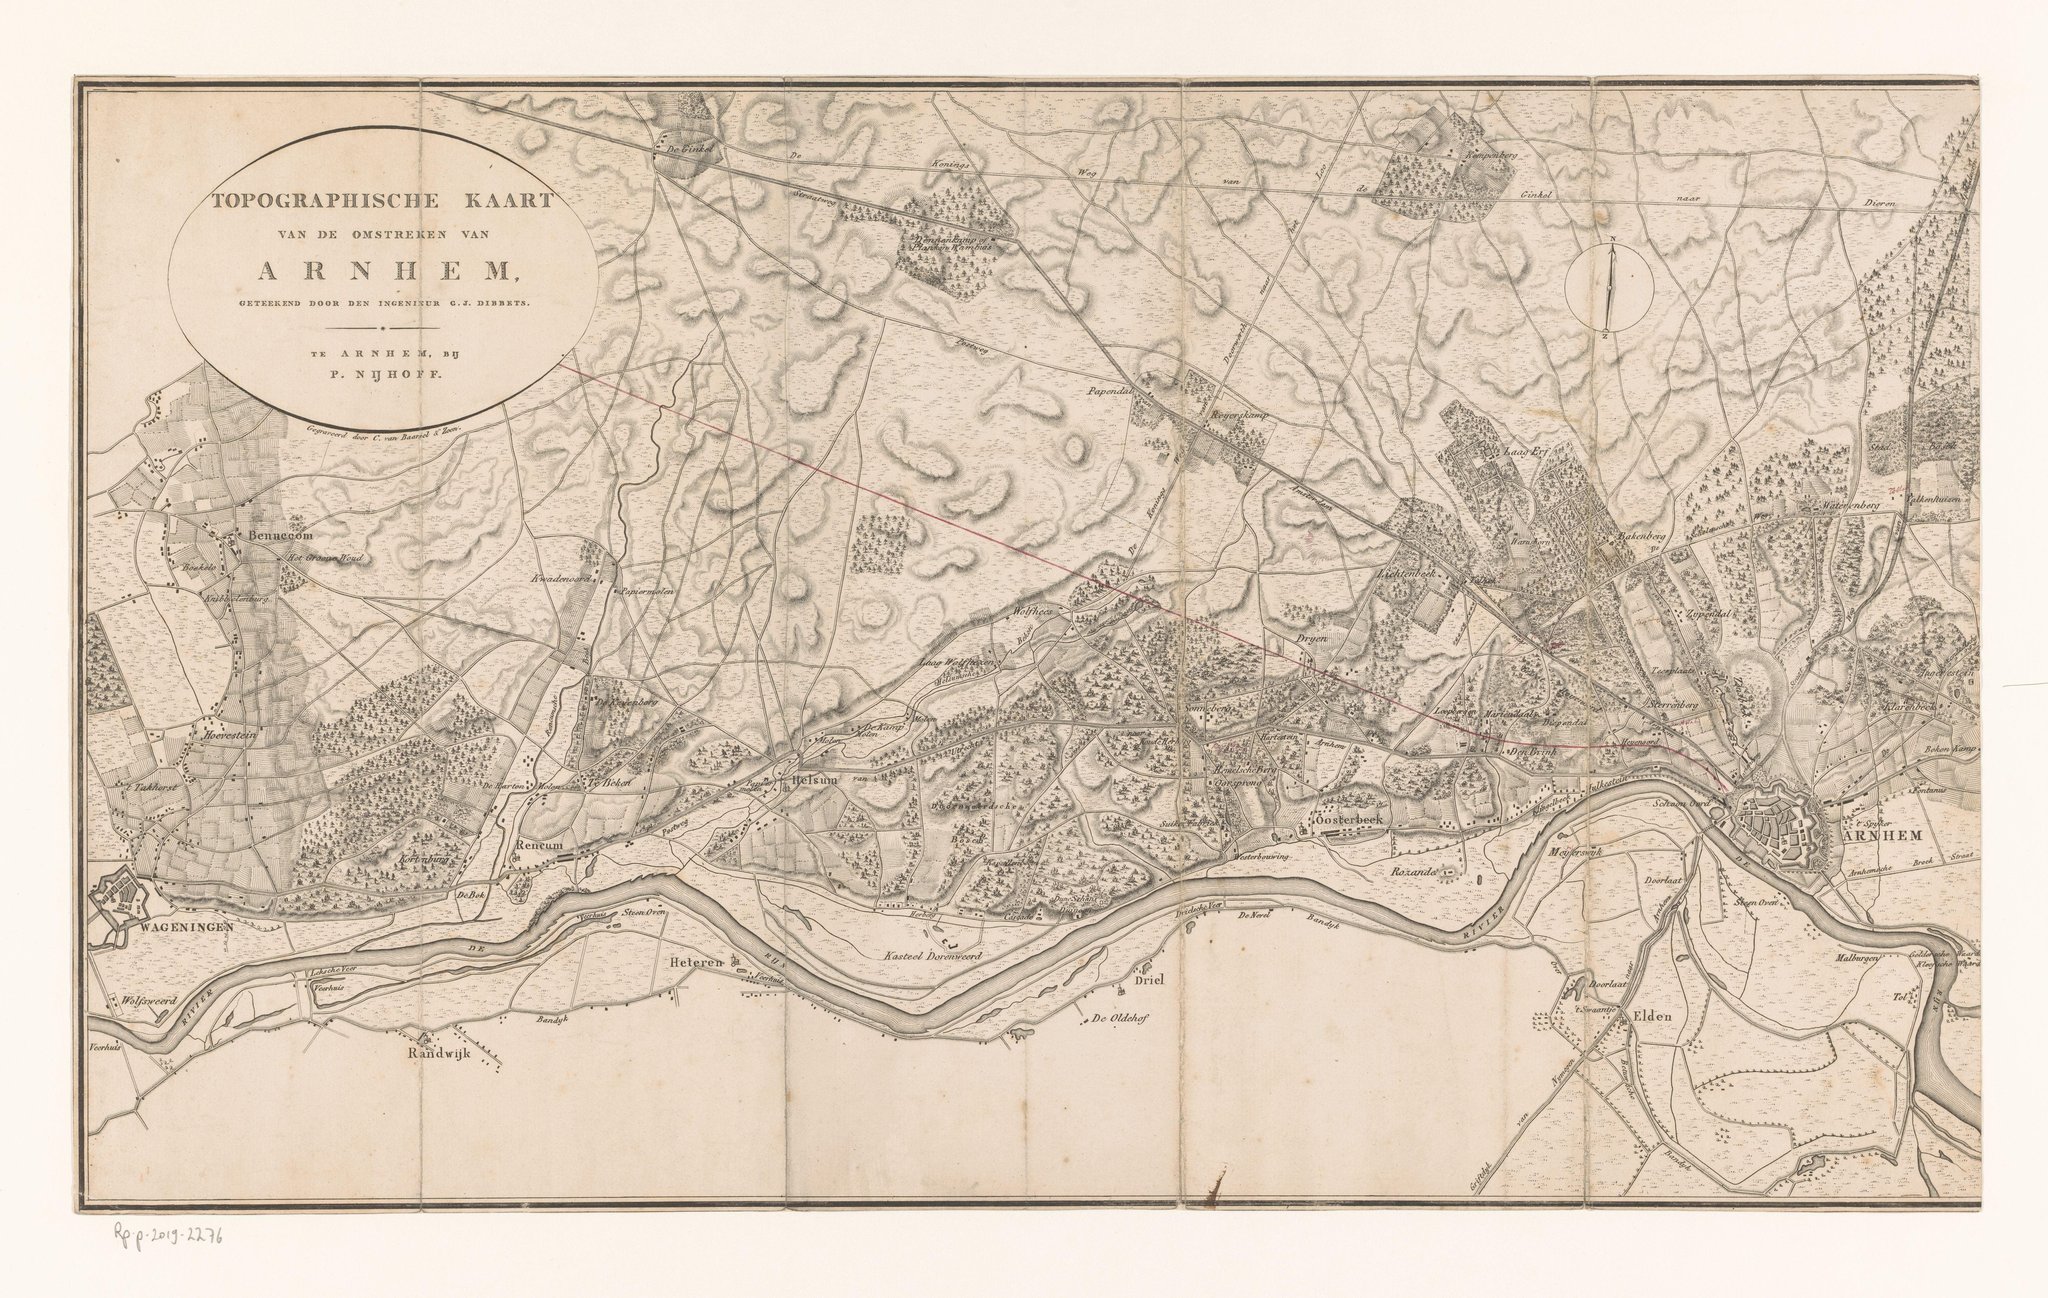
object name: print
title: Topografische kaart van de omstreken van Arnhem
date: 1839-1867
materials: ink, paper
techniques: engraving, etching, pen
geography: arnhem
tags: maps of separate countries or regions, gelderland, arnhem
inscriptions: collector's mark: Lugt 2228